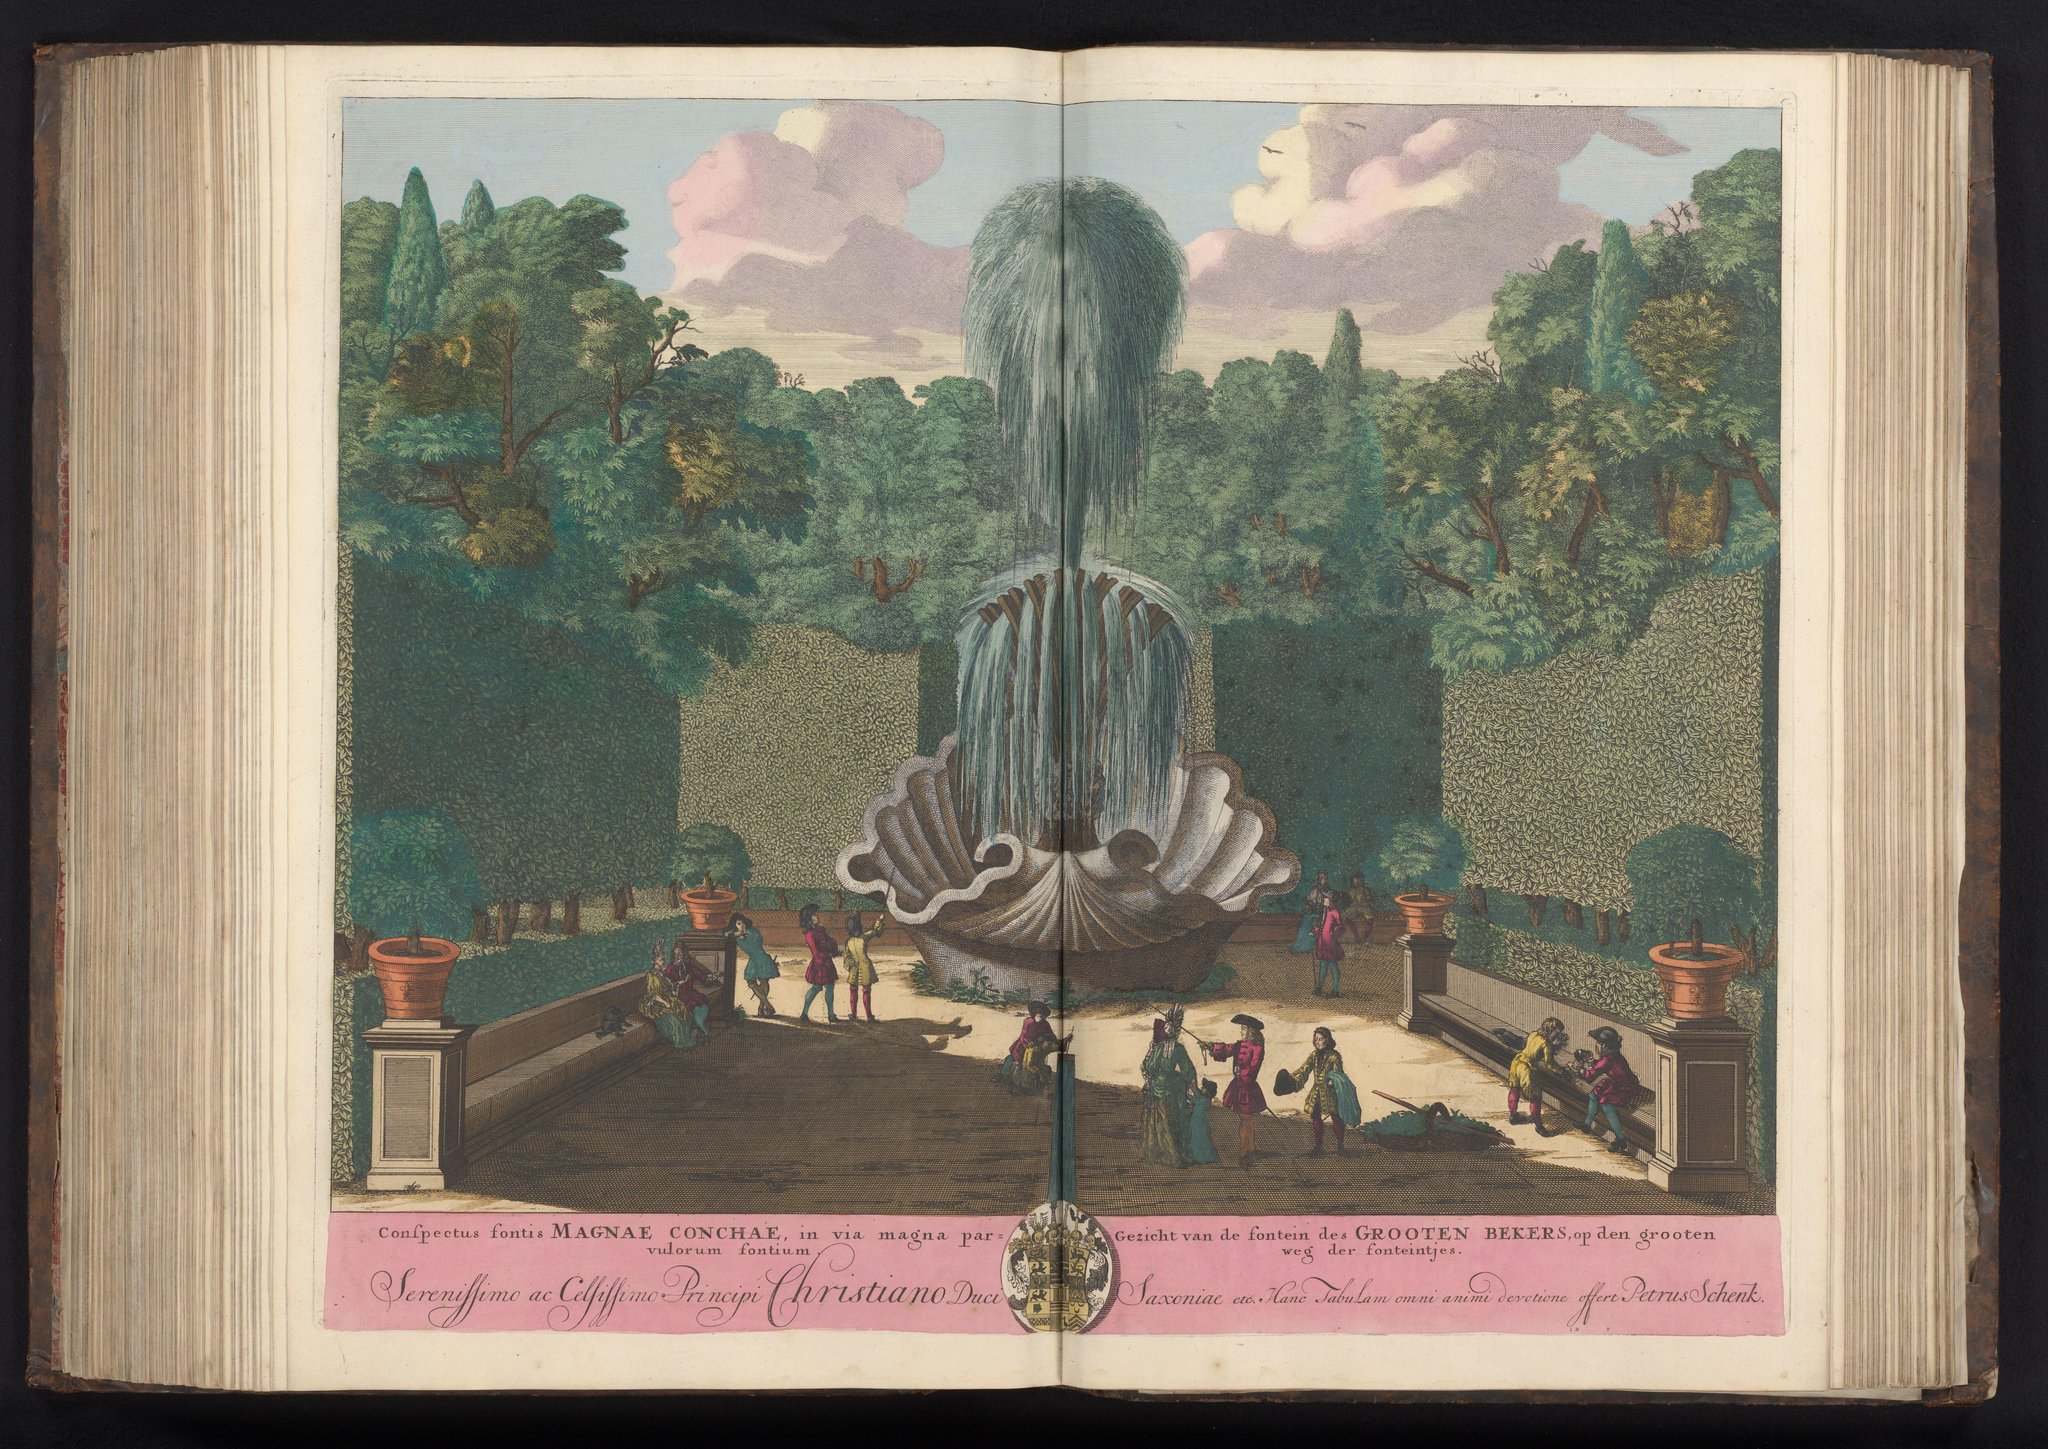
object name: print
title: Conspectus fontis magnae conchae, in via magna par vulorum fontium/ Gezicht van de fontein des grooten bekers, op den grooten weg der fonteintjes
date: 1670-1711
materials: paper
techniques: colour, etching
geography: amsterdam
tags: city-view, and landscape with man-made constructions, garden, nymphs (in general); 'ninfe in commune' (ripa), piece of sculpture, reproduction of a piece of sculpture, ornamental fountain, tivoli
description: Gezicht op de Schelpfontein in de tuin van de Villa d'Este te Tivoli. Titel in het Latijn en in het Nederlands in de ondermarge. Prent maakt deel uit van een album.